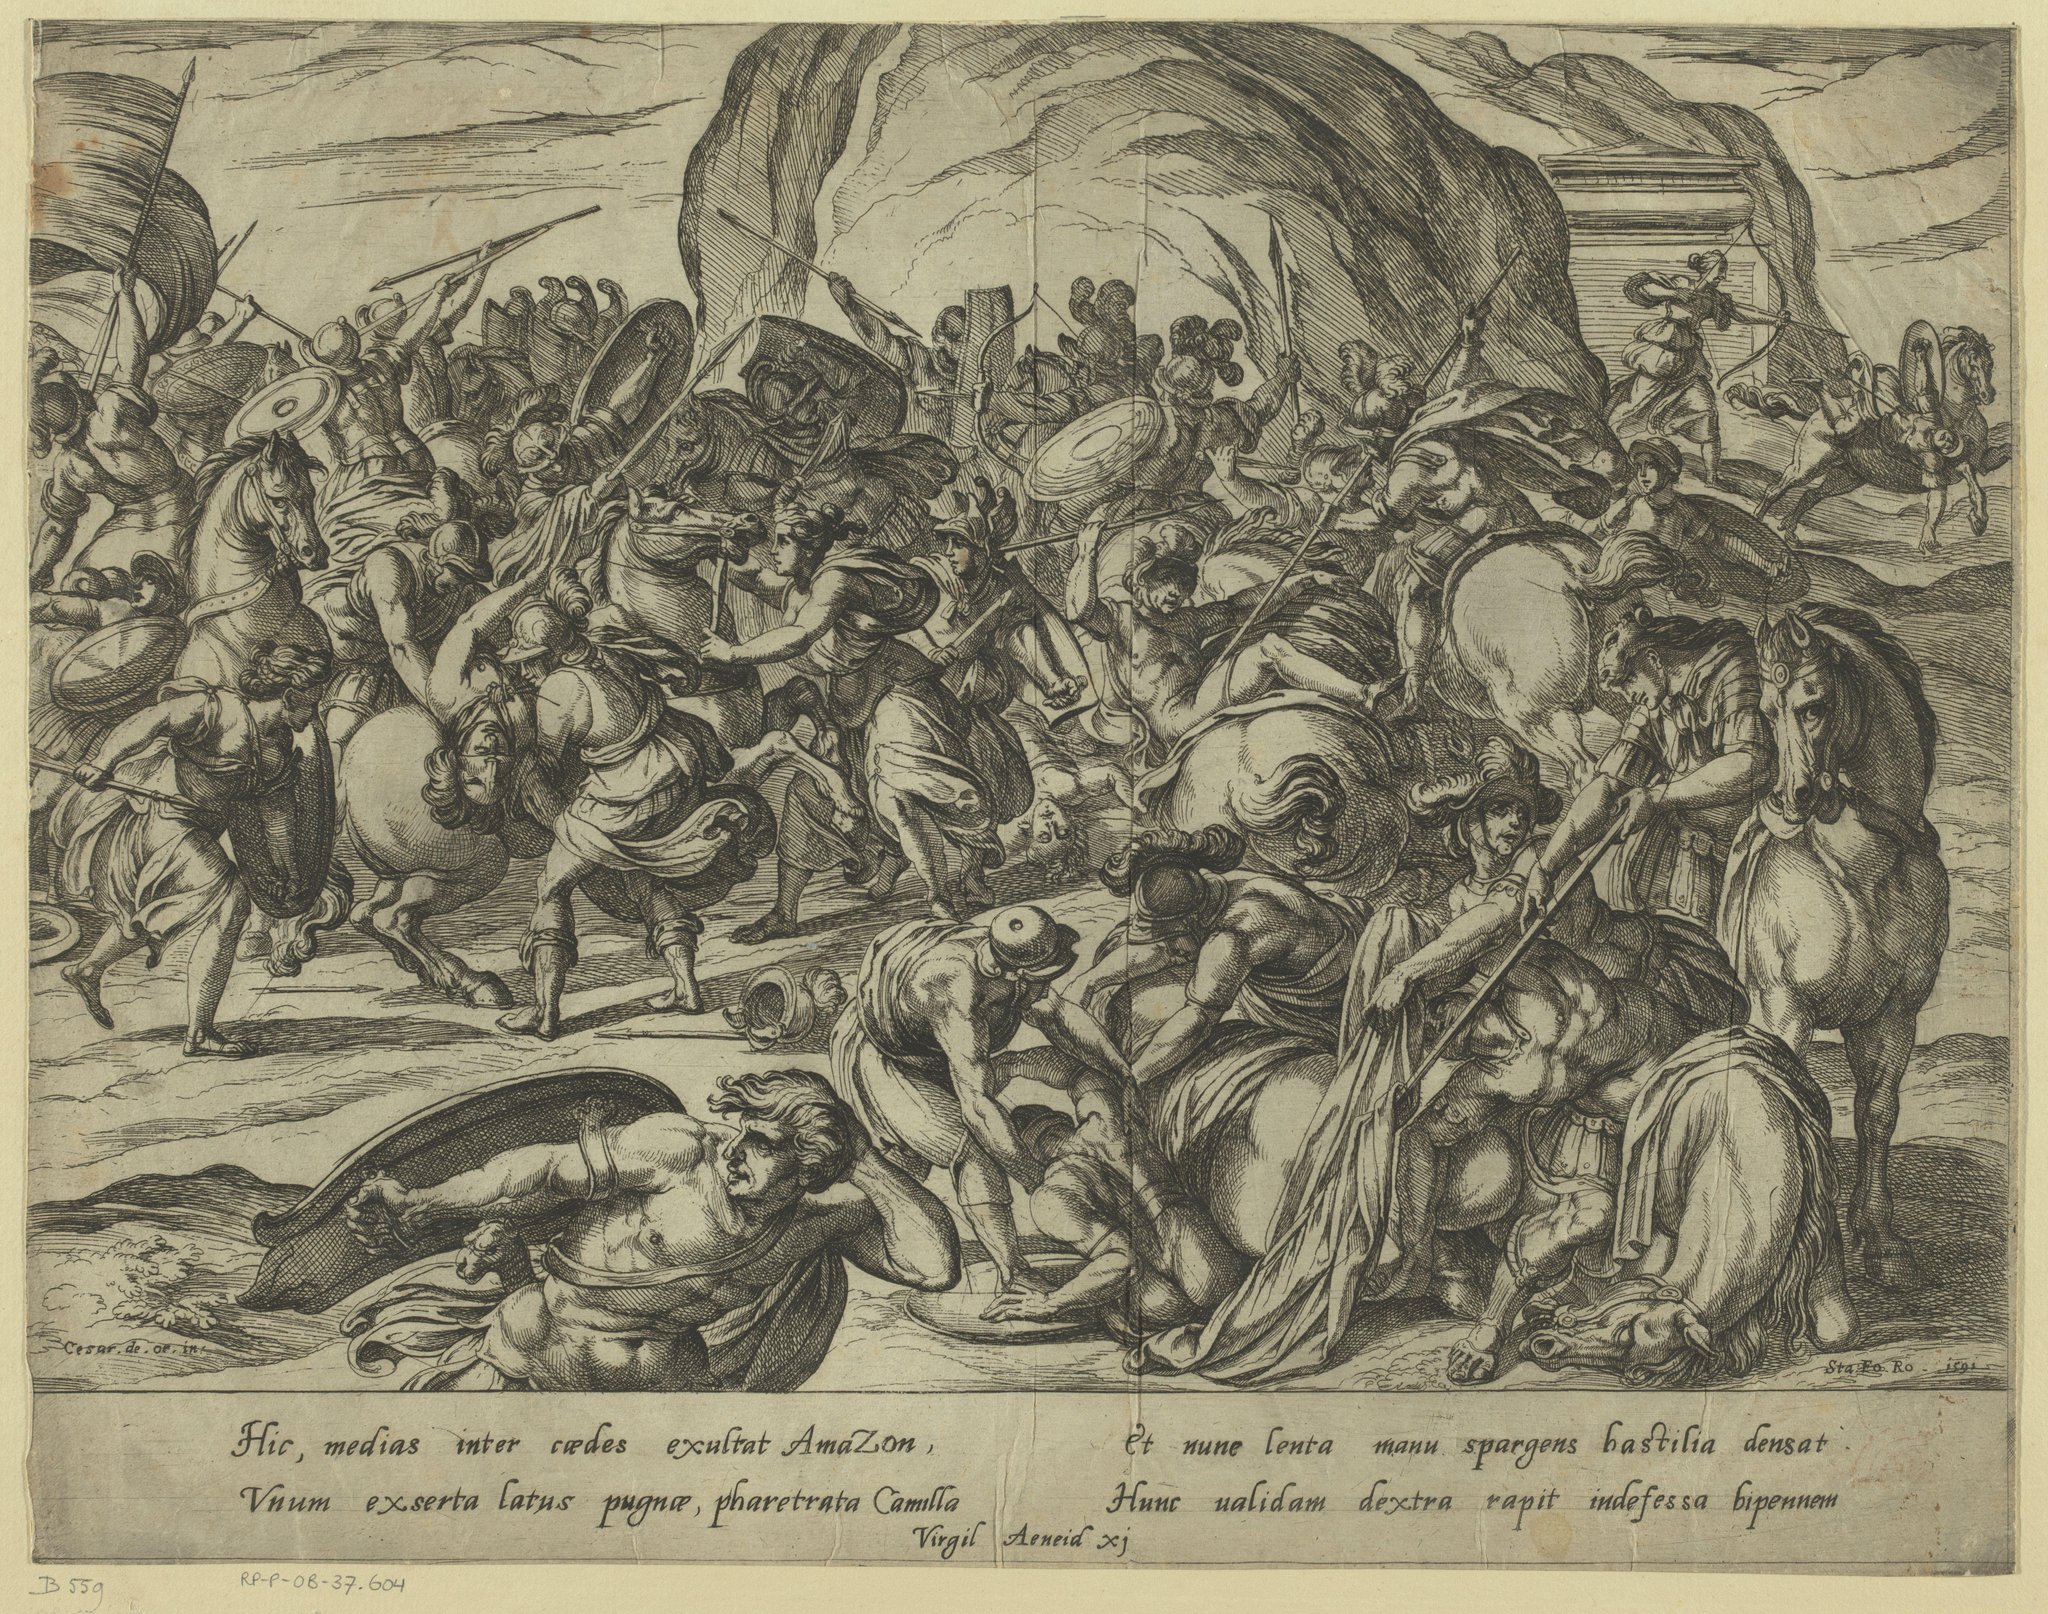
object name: print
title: De dood van Camillus in de strijd tussen Grieken en Romeinen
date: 1591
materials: paper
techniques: etching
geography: italy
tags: (story of) camilla - death, battle, the soldier; the soldier's life, warfare; military affairs (+ land forces)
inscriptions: collector's mark: Lugt 240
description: De dood van Camillus in een strijdgewoel van Griekse en Romeinse soldaten te paard. Vers in het Latijn in ondermarge.